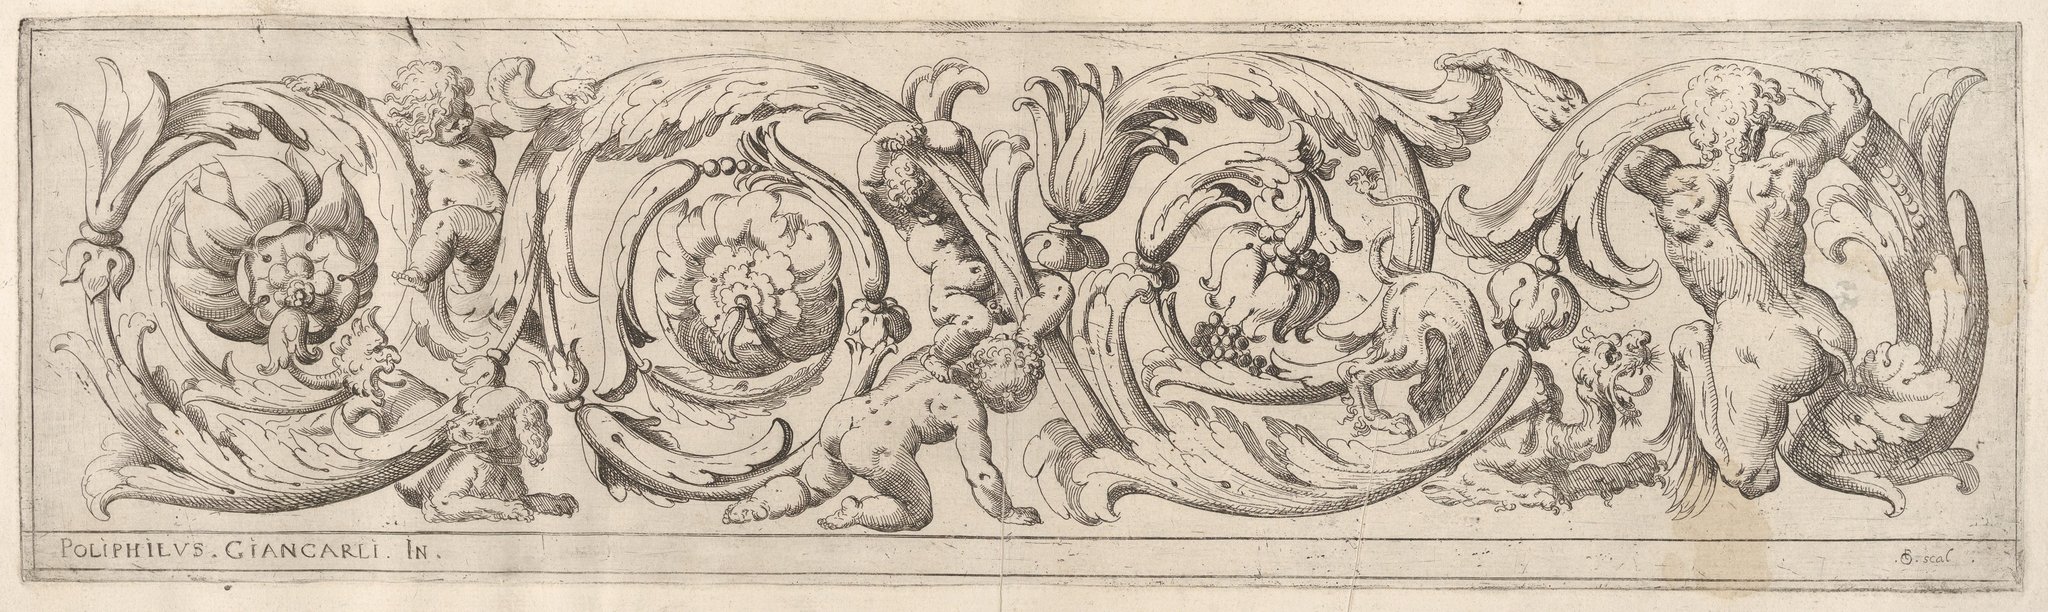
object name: collection ornament architecture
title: Disegni Varij di Polifilo Zancarli (Friezes)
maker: polifilo giancarli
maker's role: artist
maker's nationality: italian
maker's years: 1600-1625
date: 1625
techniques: etching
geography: italy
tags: satyrs,dogs